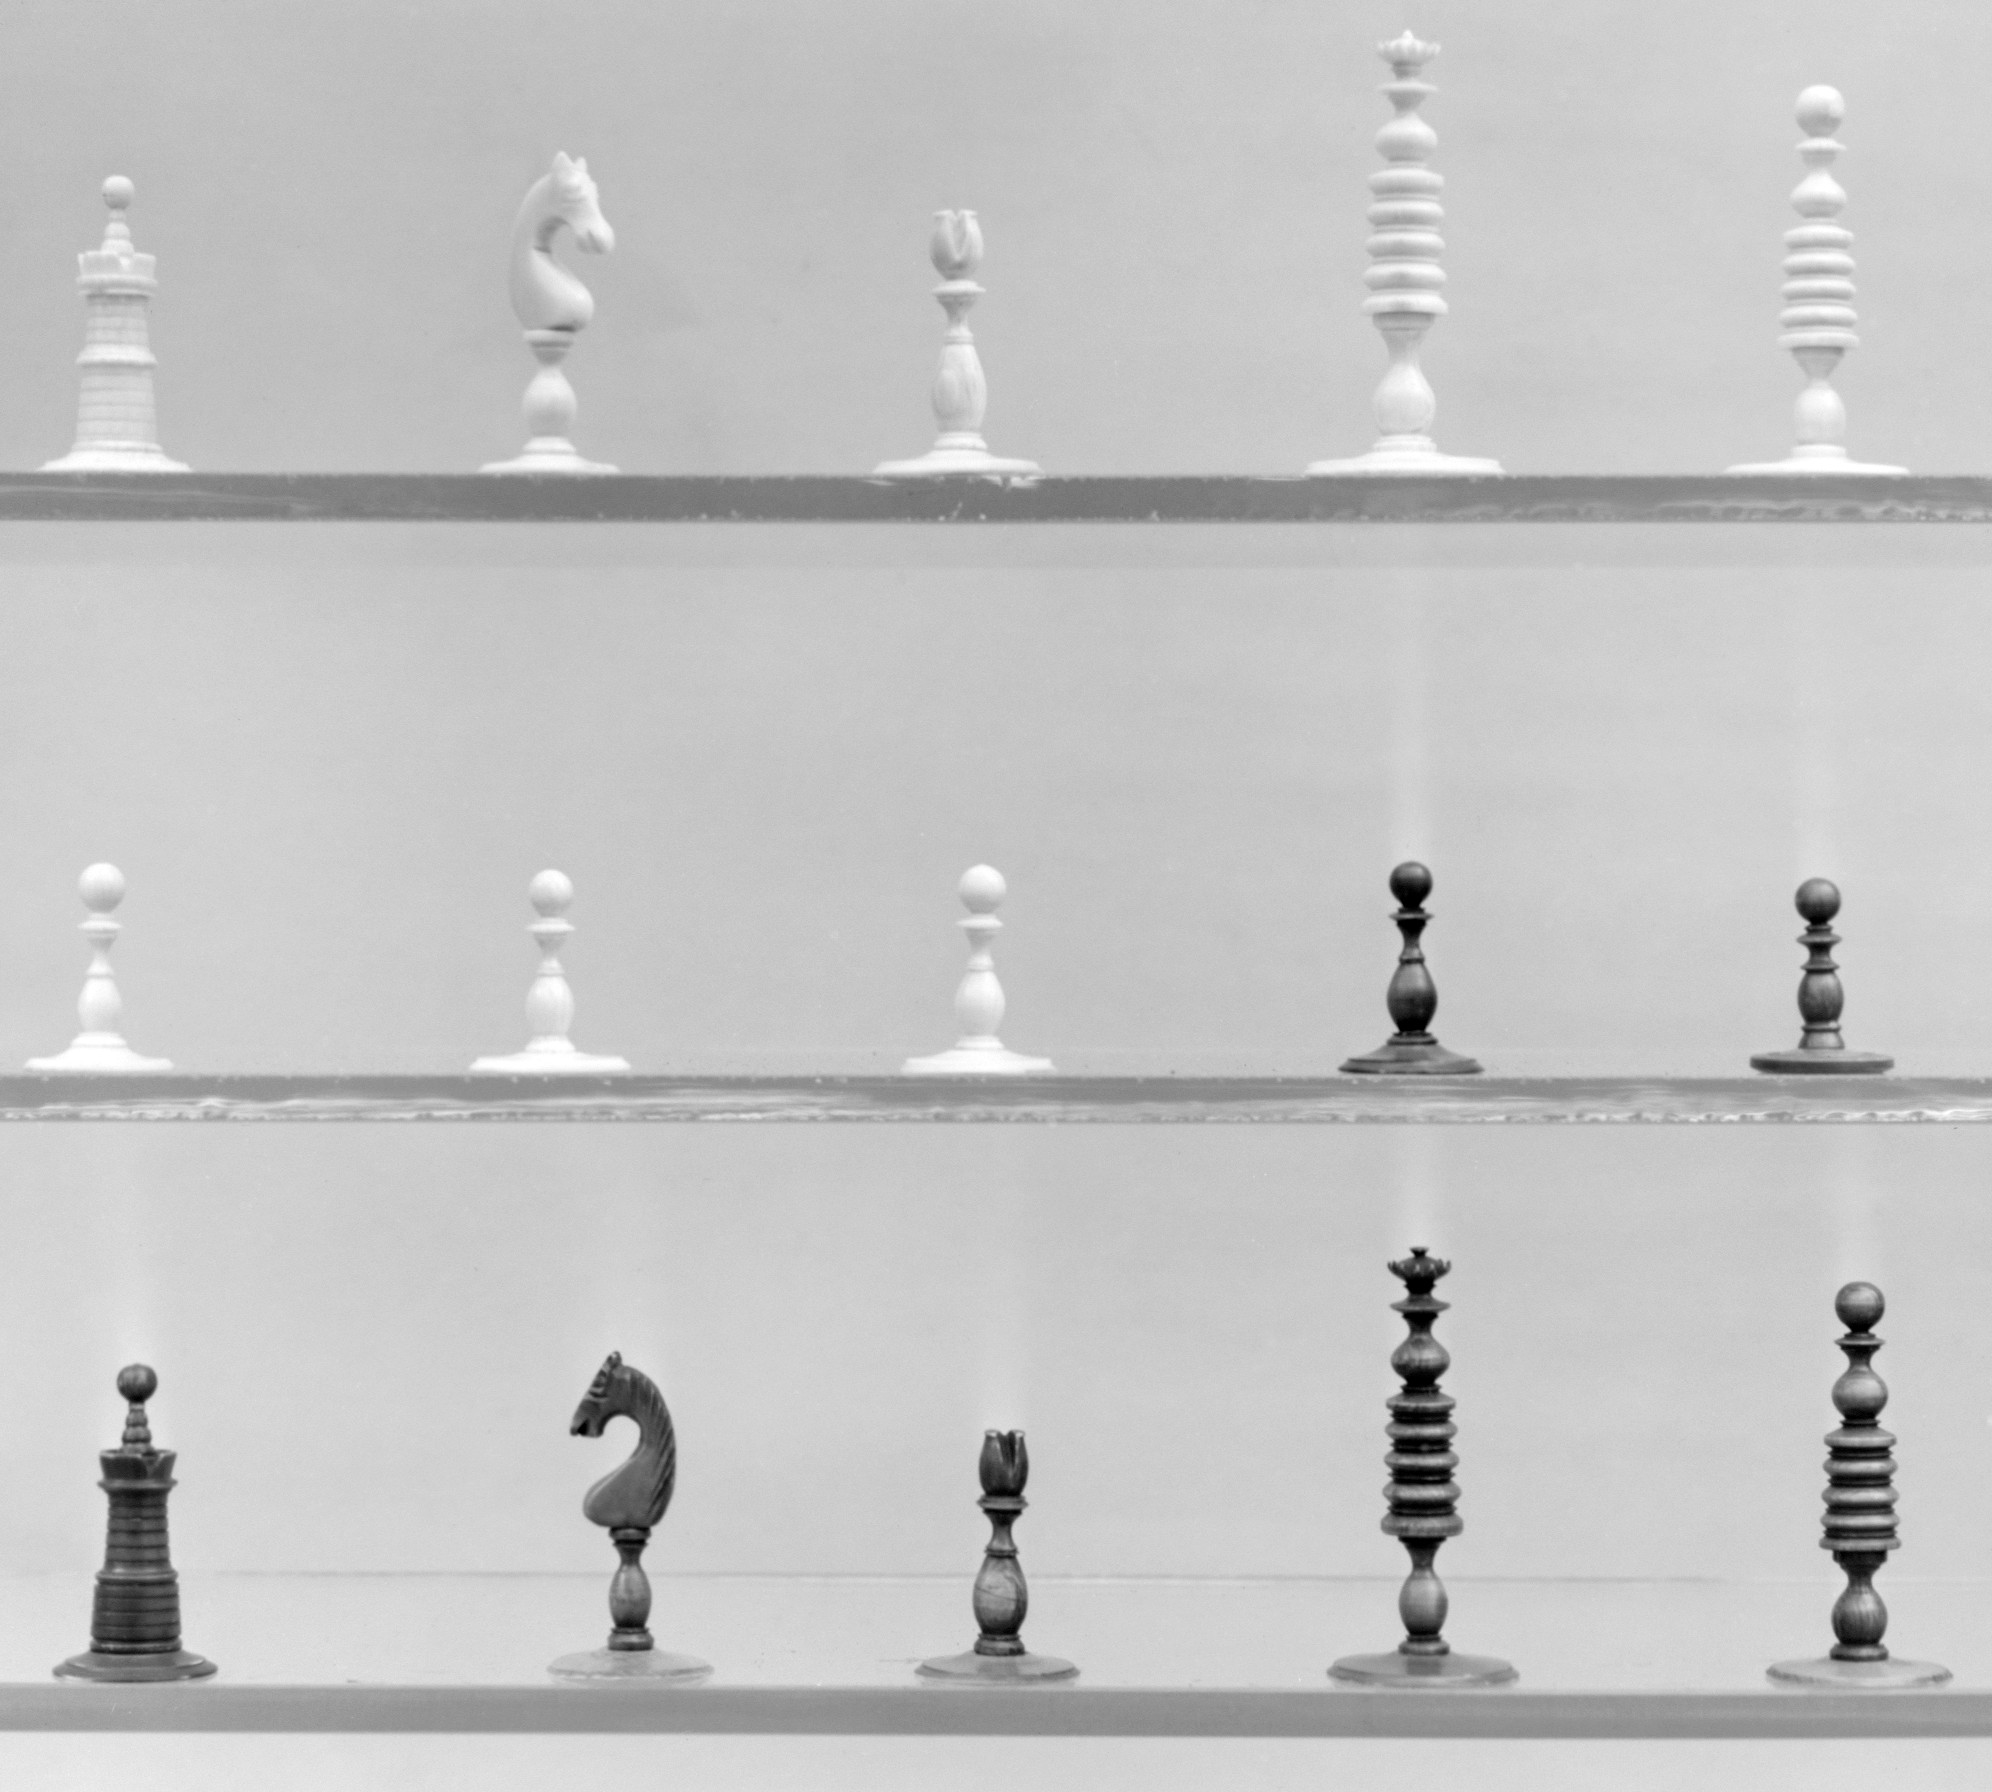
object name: chessman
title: Chessmen (32)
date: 1801-1900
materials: ivory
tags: chess